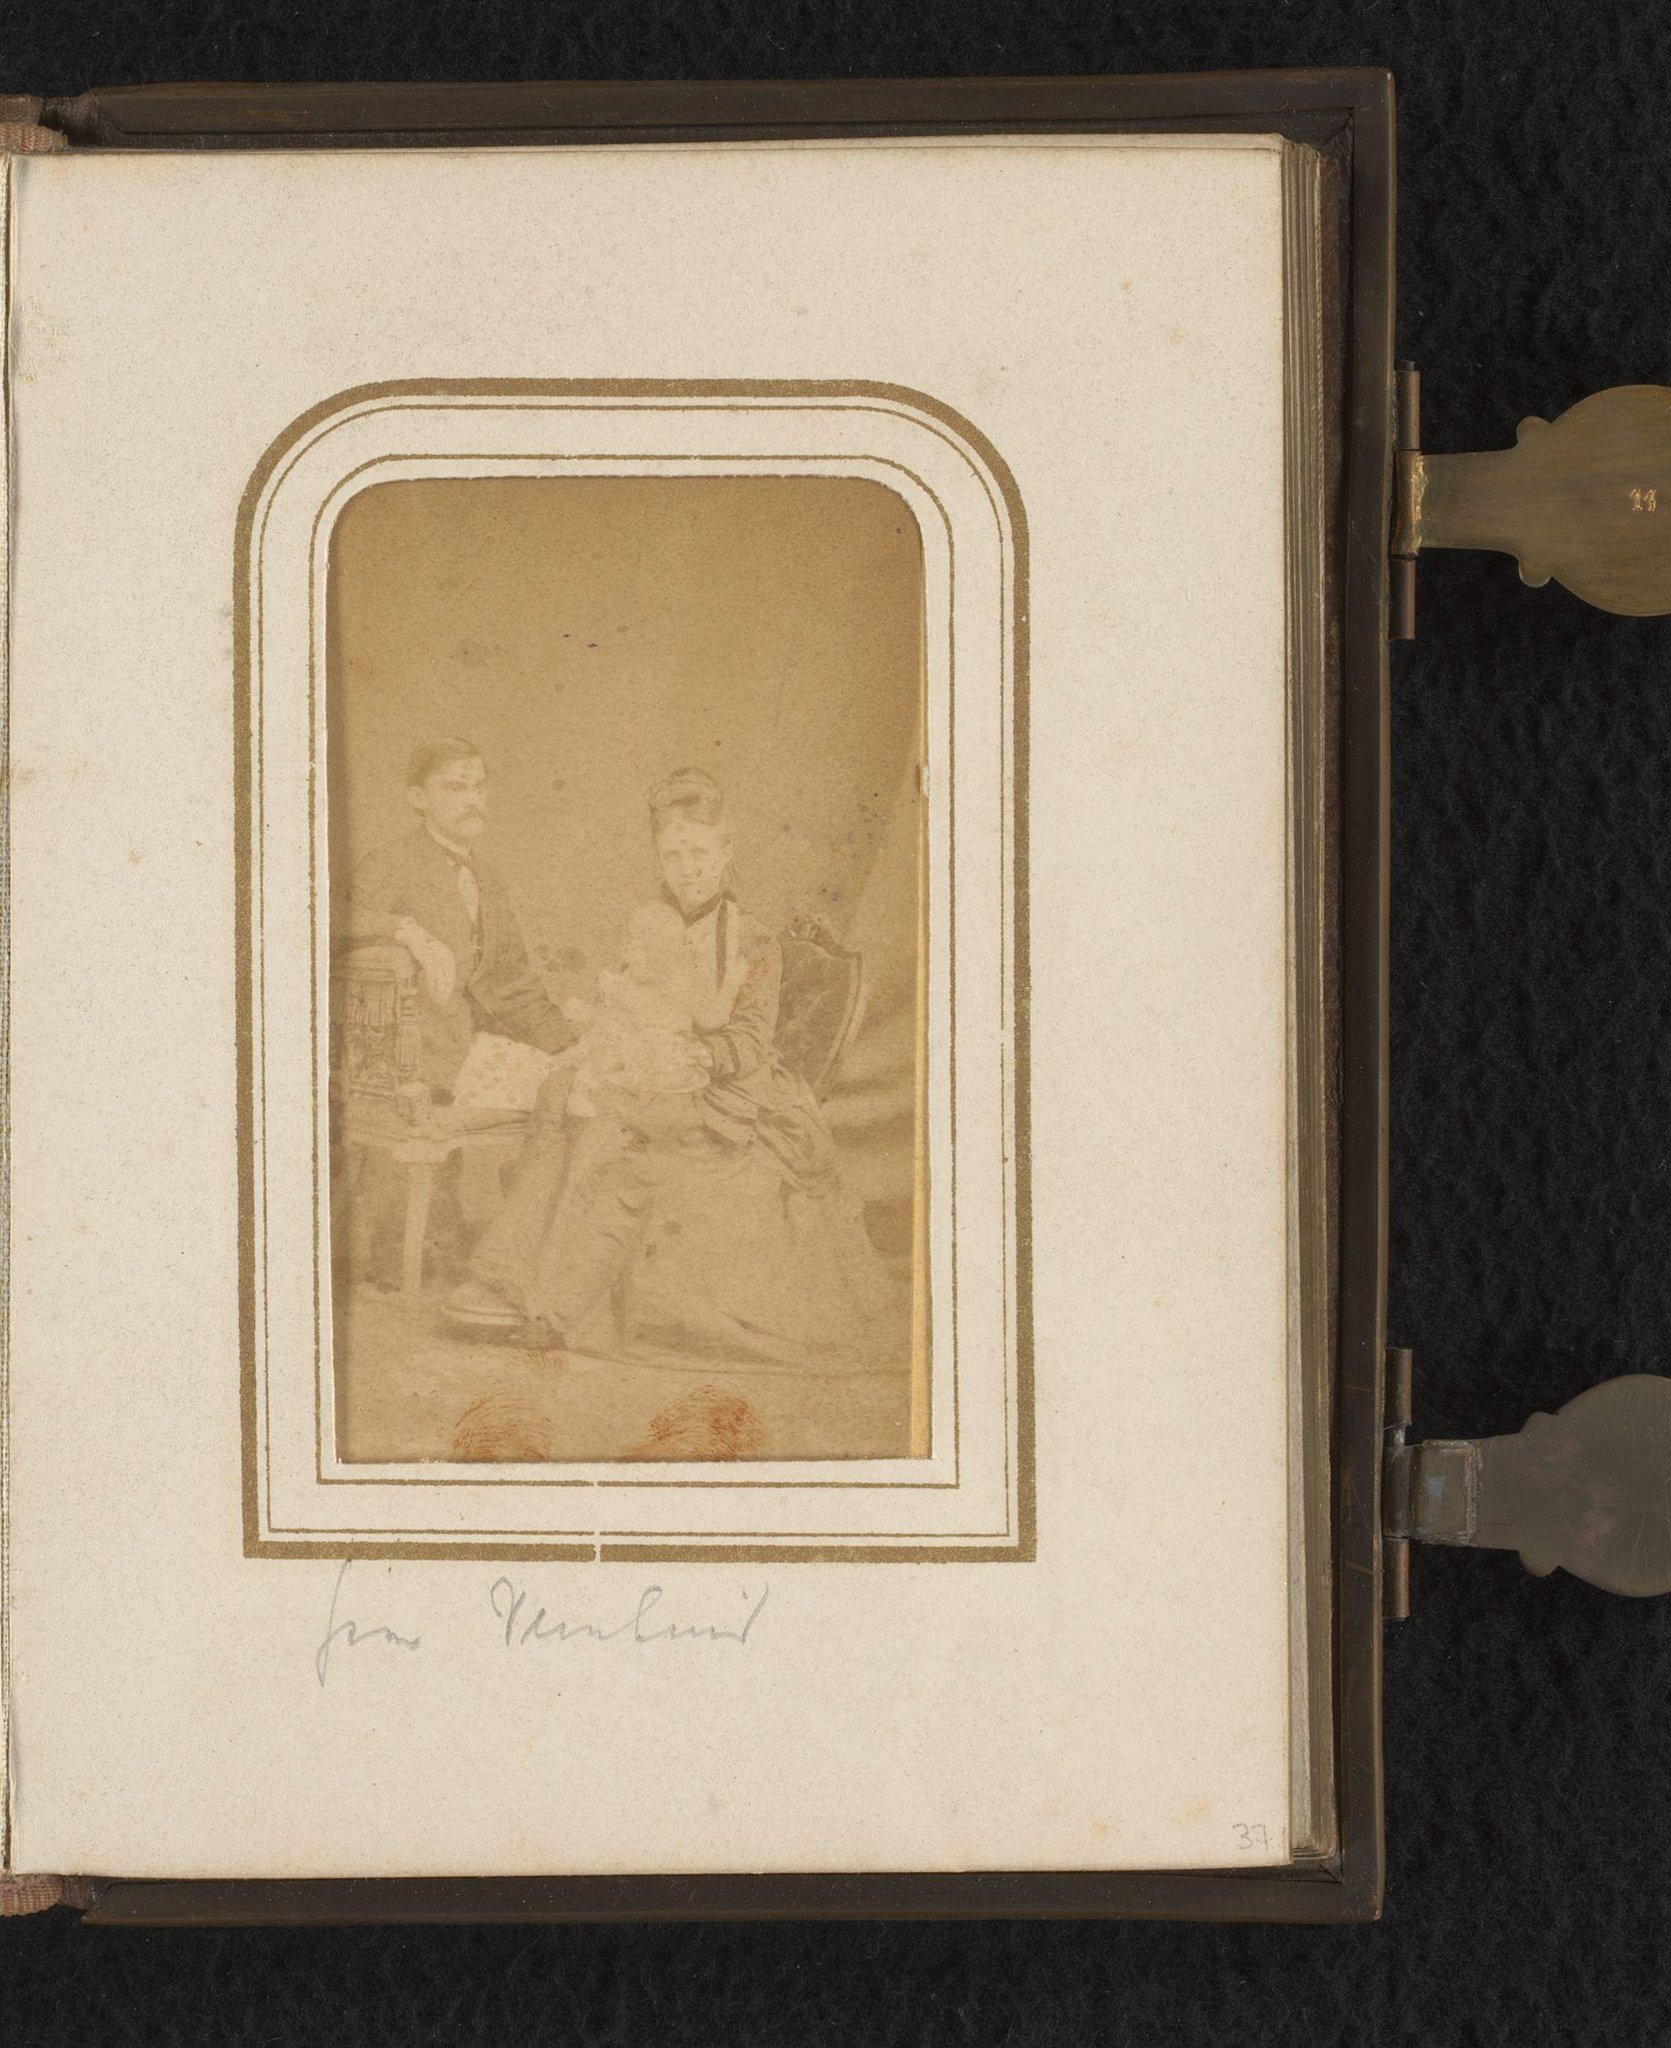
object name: album leaf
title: Portret van een zittende man en vrouw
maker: Anonymous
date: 1860-1900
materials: cardboard, photographic support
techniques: albumen print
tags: sitting figure, adult woman, adult man, historical persons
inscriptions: annotation: ‘fam Versch[...]’